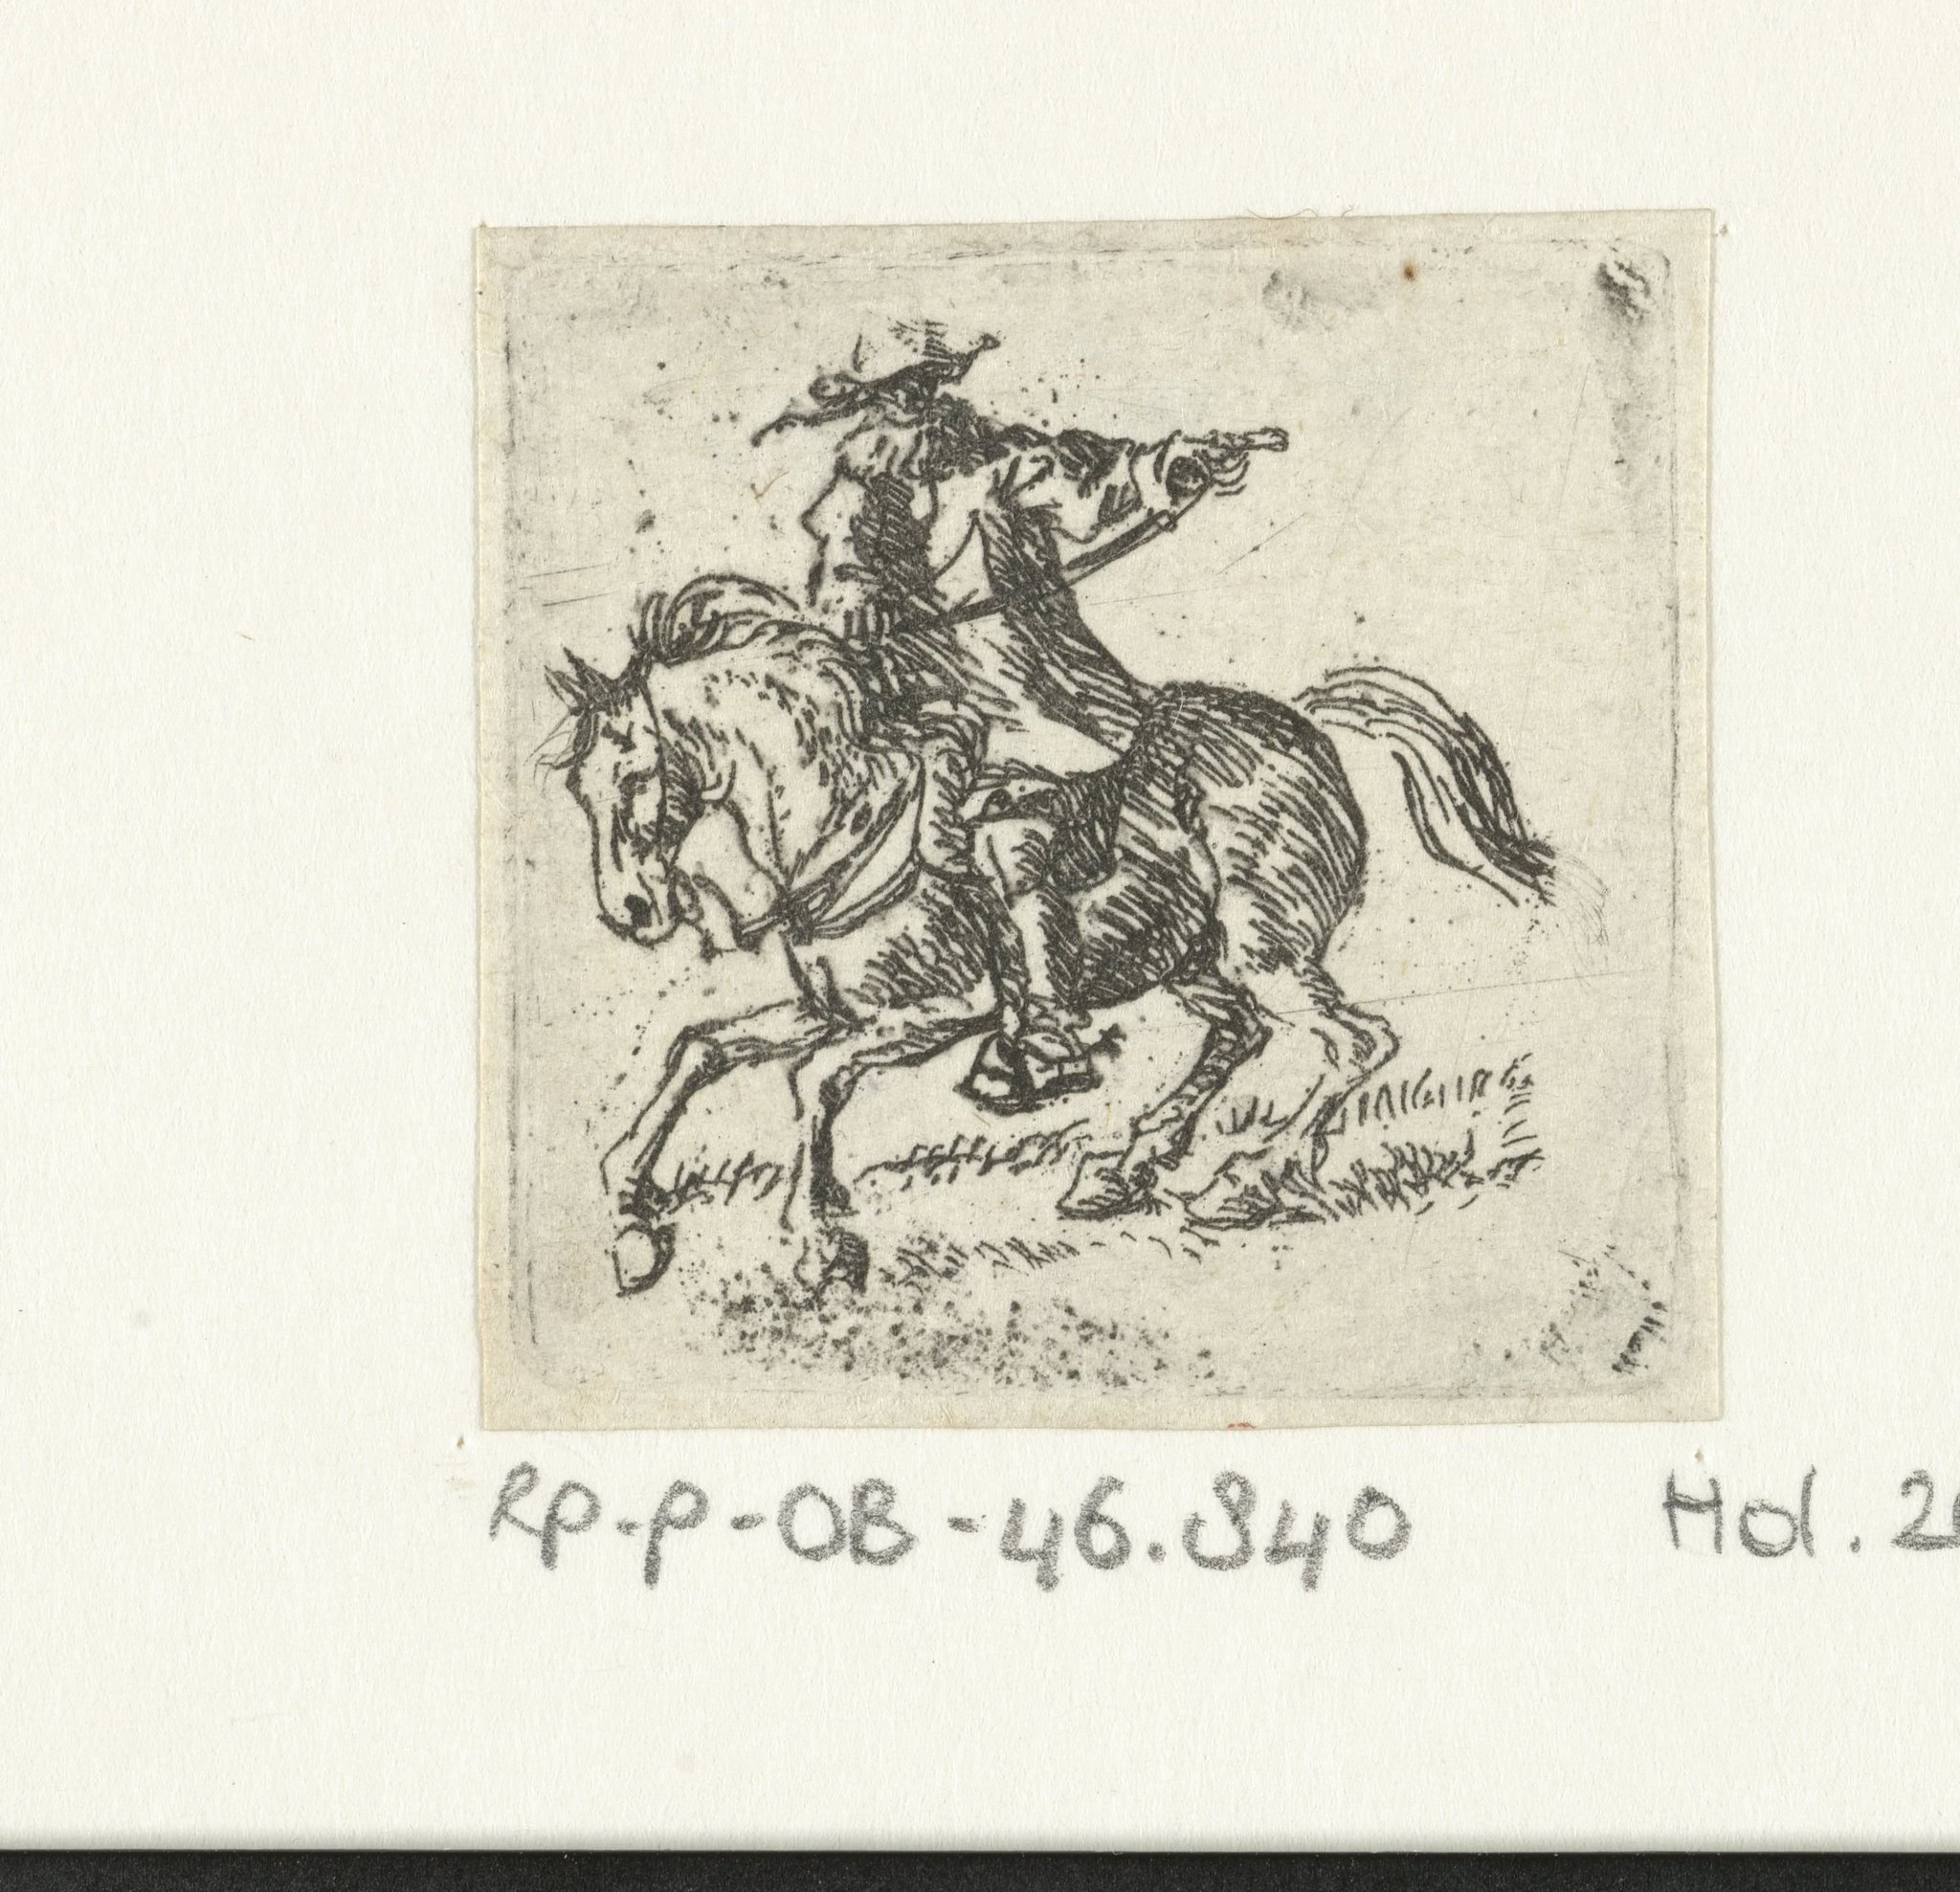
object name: print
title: Ruiter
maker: pieter bodding van laer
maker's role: draughtsman, painter, print maker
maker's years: 1599-1642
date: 1609-1642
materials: paper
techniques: etching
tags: riding a horse, ass, or mule; rider, horseman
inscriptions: collector's mark: Lugt 240